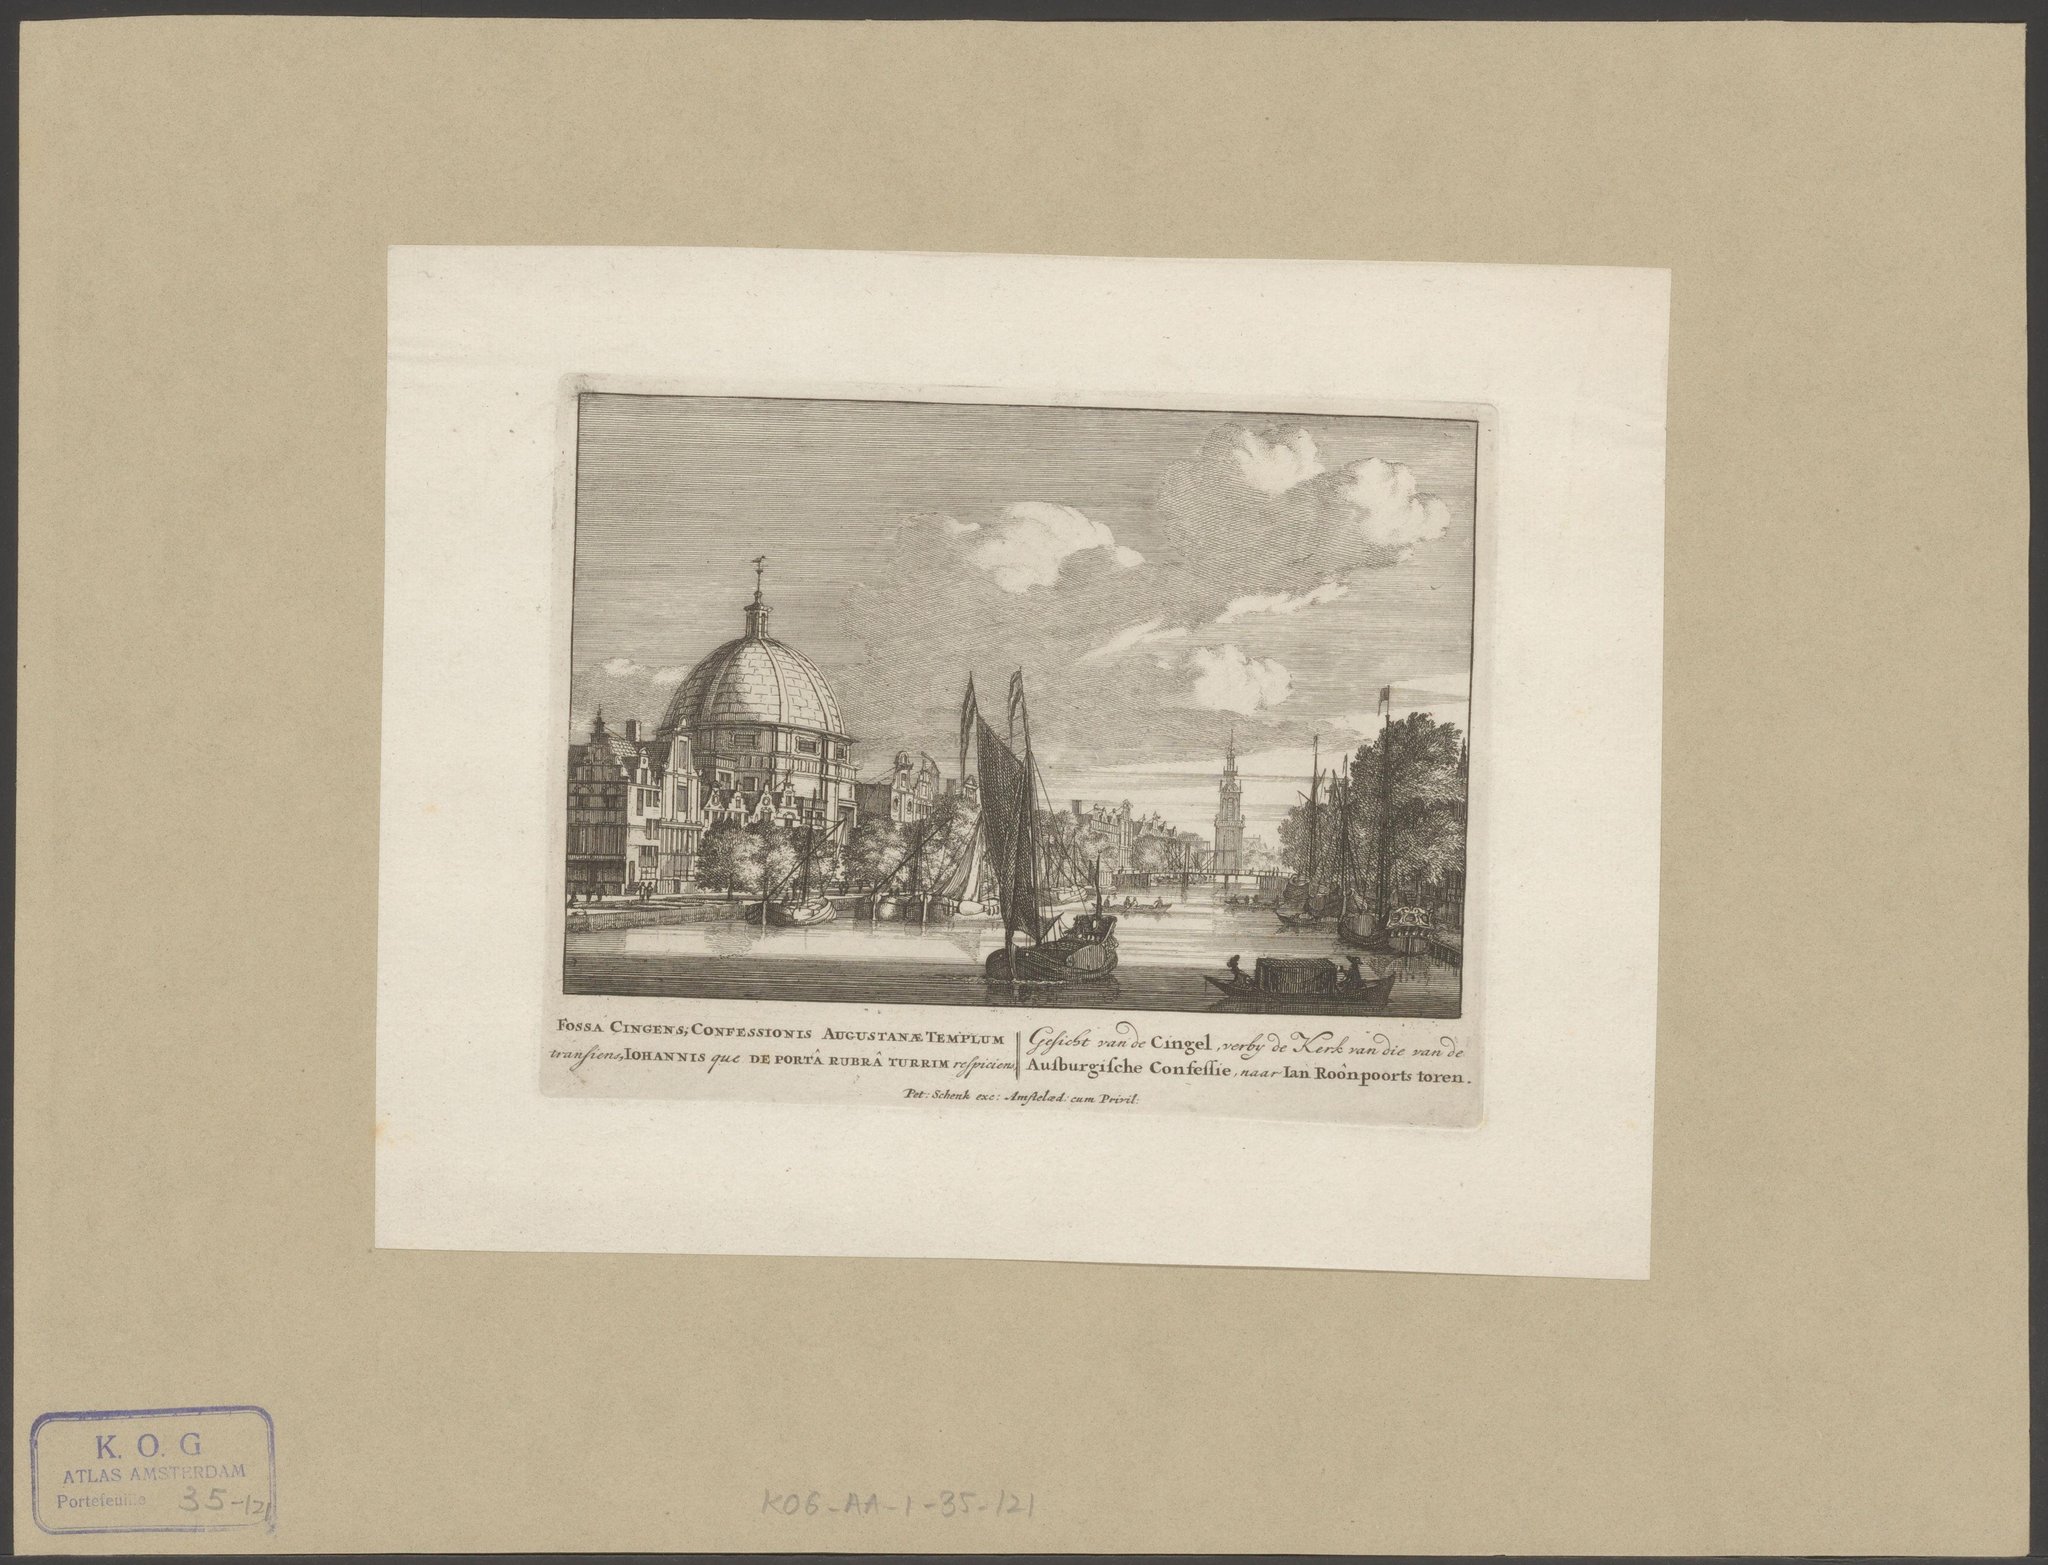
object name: book illustration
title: Viervoudig schouwspel van wonderen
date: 1694-1697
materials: paper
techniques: etching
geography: amsterdam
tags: sailing-ship, sailing-boat, tower, clock tower ~ monumental adornment, city-view in general; 'veduta', canal, church (exterior)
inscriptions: collector's mark: ‘35-121’ Lugt 1641b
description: Prent uit: Call, Jan van. Admirandorum Quadruplex Spectaculum. Amsterdam: Pieter Schenk (I), 1700. De titelprent, opdracht en het portret van Frederik van Saksen zijn gegraveerd door Pieter Schenk (I). De overige prenten uit deze serie zijn, zoals aangegeven op de titelprent, van de hand van Jan van Call (I).